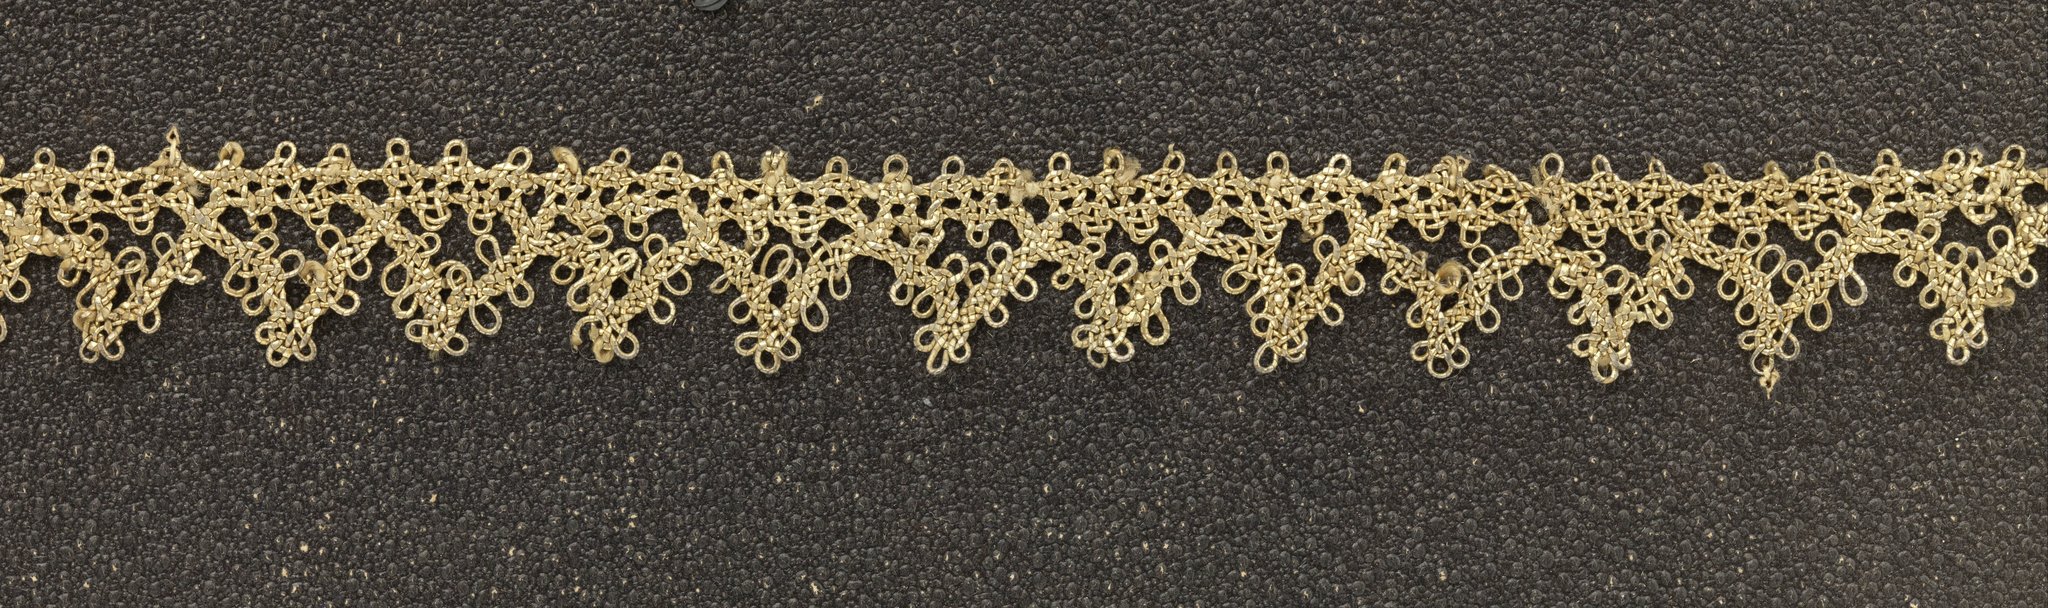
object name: braid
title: Strook van goudkant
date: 1700-1800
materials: gold thread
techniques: gold lace